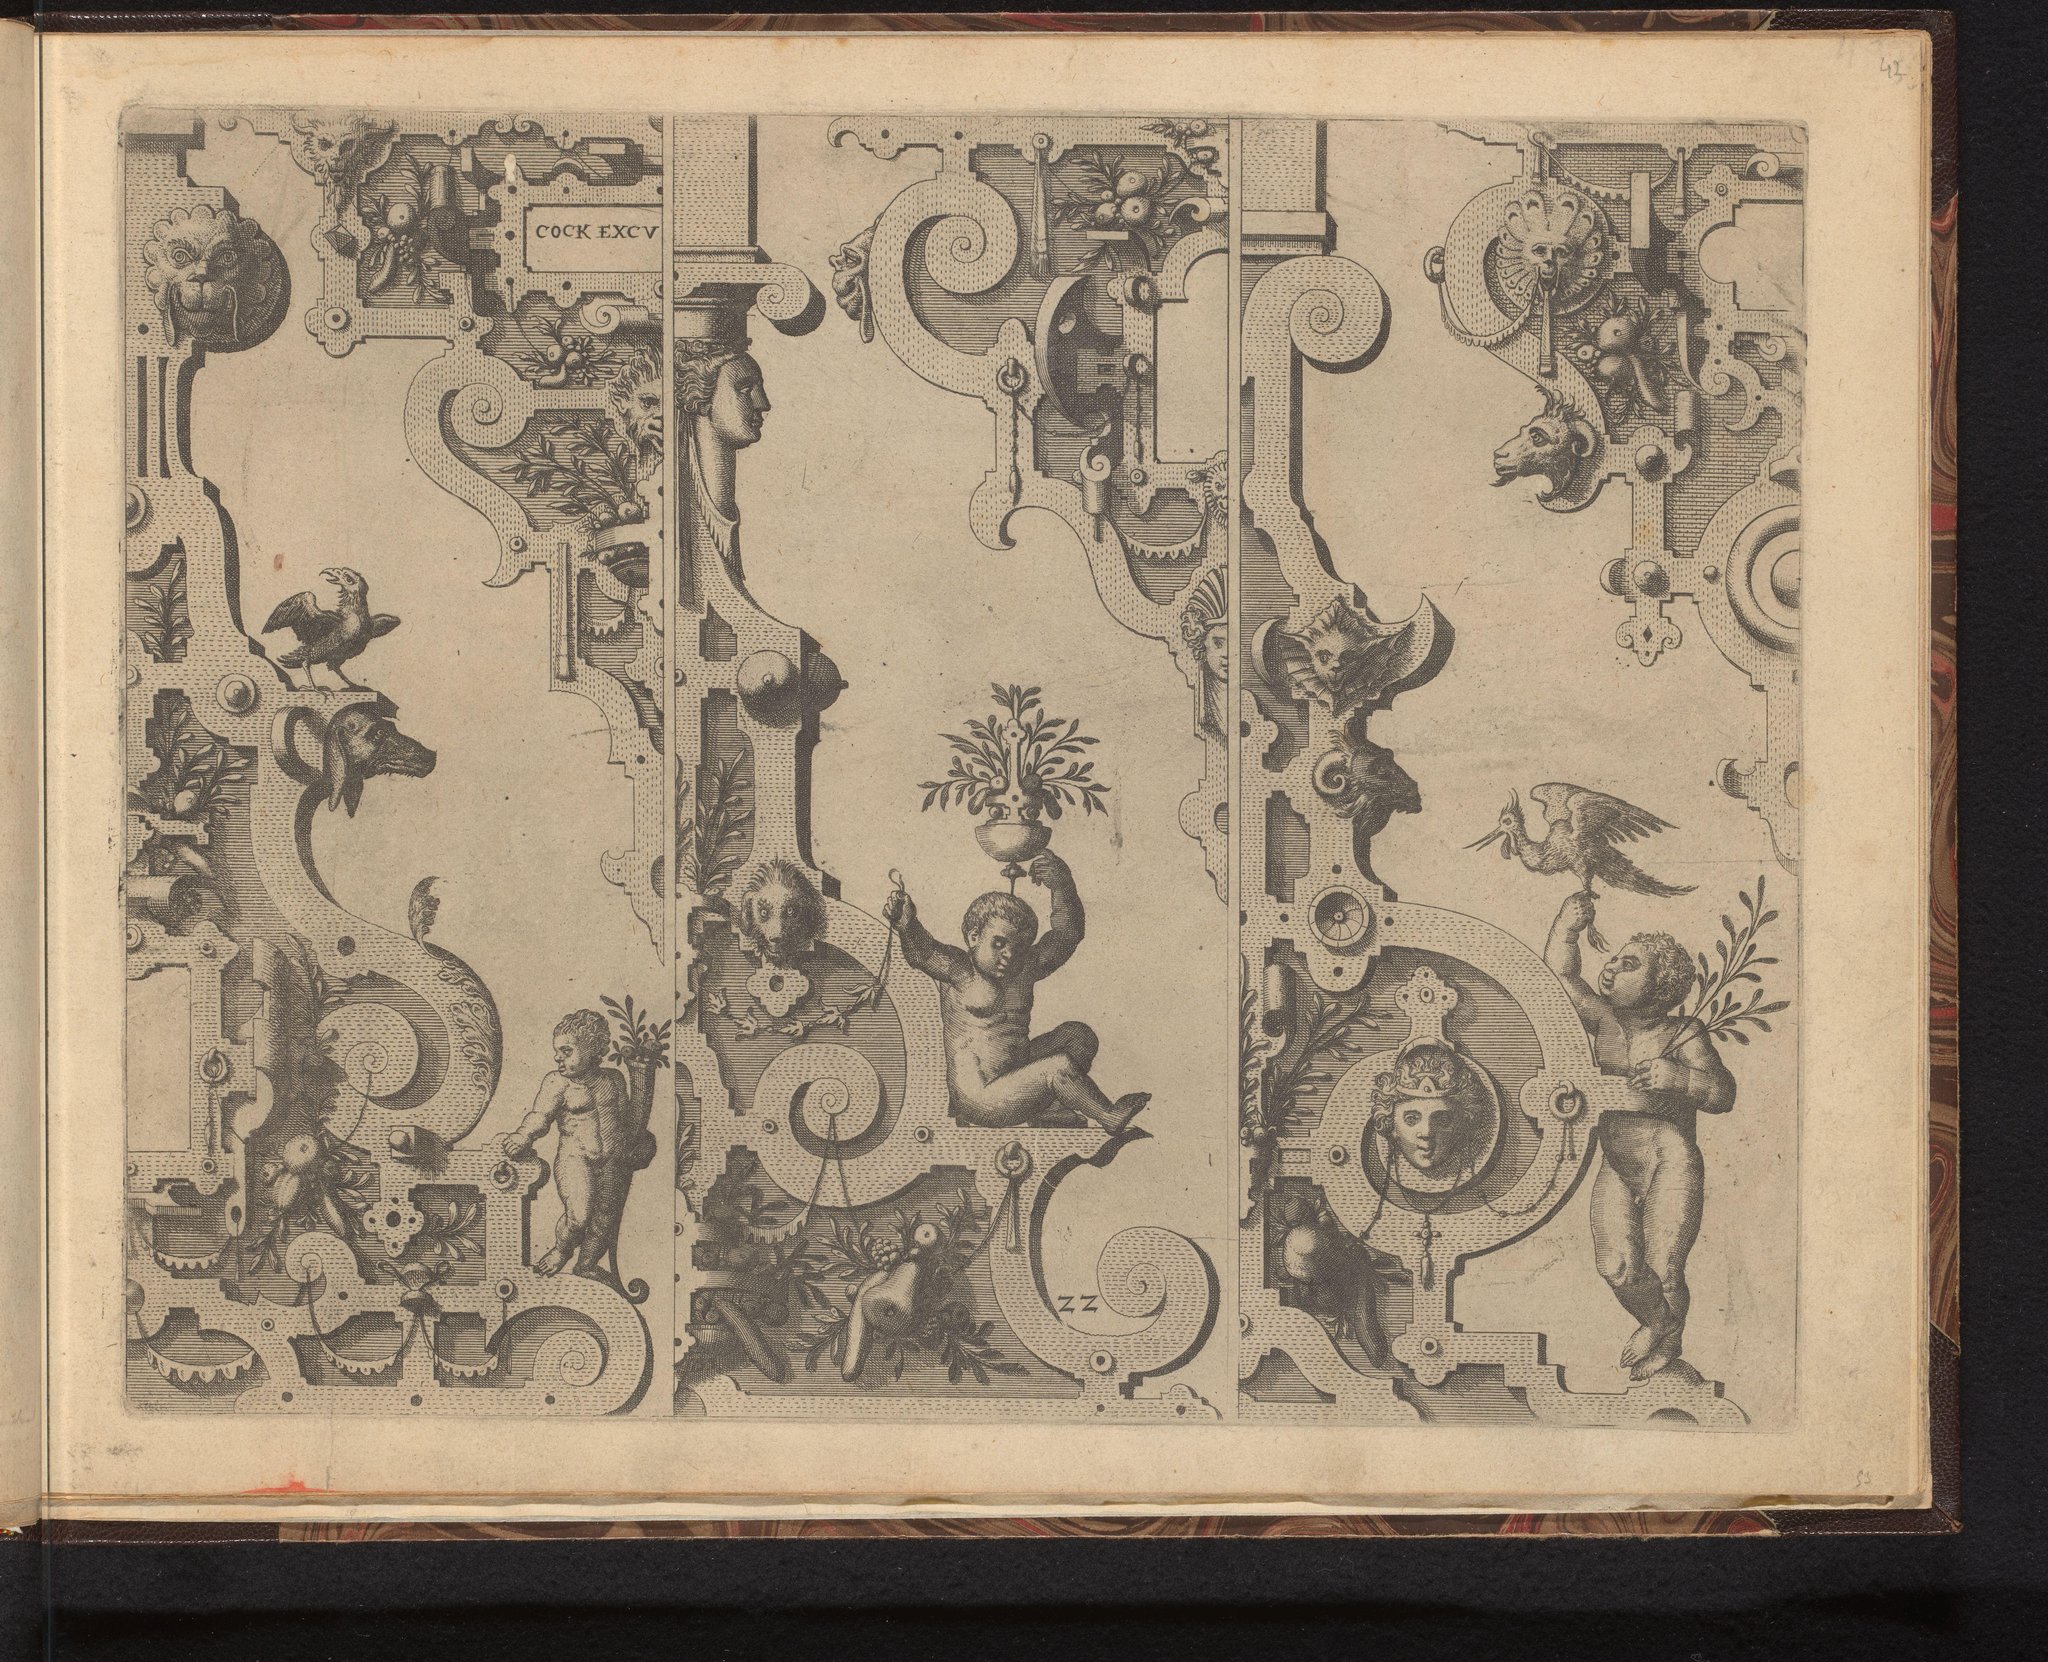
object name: print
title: Drie klauwstukken en drie zwikstukken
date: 1565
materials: paper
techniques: etching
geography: antwerp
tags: composite order ~ architecture, corinthian order ~ architecture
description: Drie segmenten met in totaal drie halve klauwstukken en drie halve zwikstukken, gedecoreerd met cartouches, beslagwerk, grotesken en guirlandes. Op elk klauwstuk een kind. De prent maakt deel uit van een album.